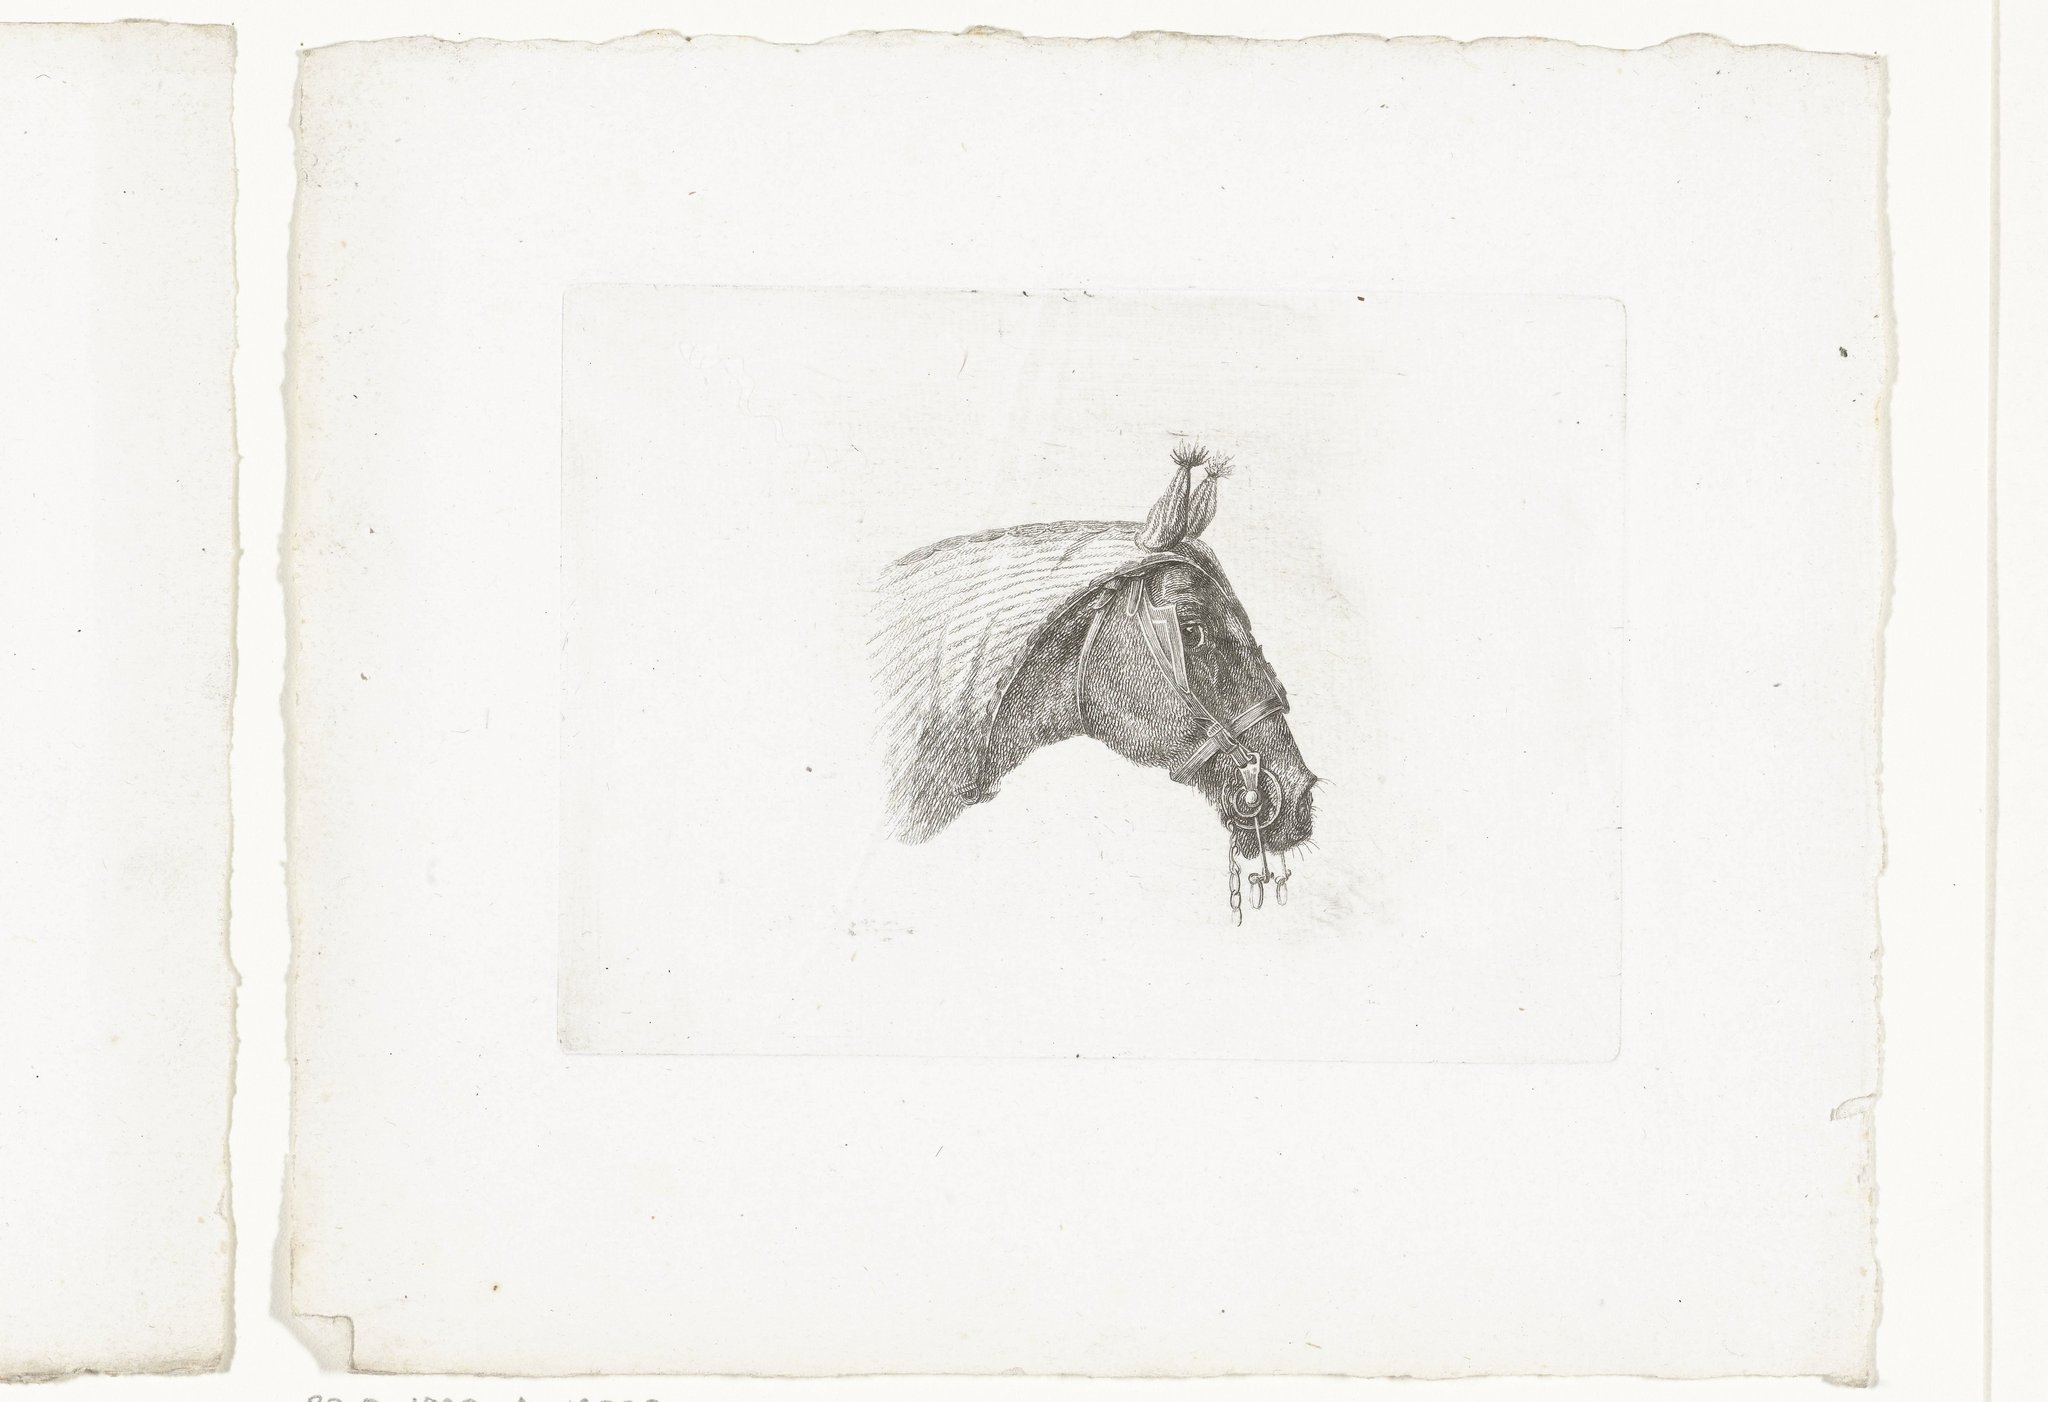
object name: print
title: Paardenhoofden naar Gerrit Malleyn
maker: joannes bemme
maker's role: print maker, printer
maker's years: 1775-1841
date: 1801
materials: paper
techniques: etching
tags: horse (+ head of an animal)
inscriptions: collector's mark: Lugt 2228